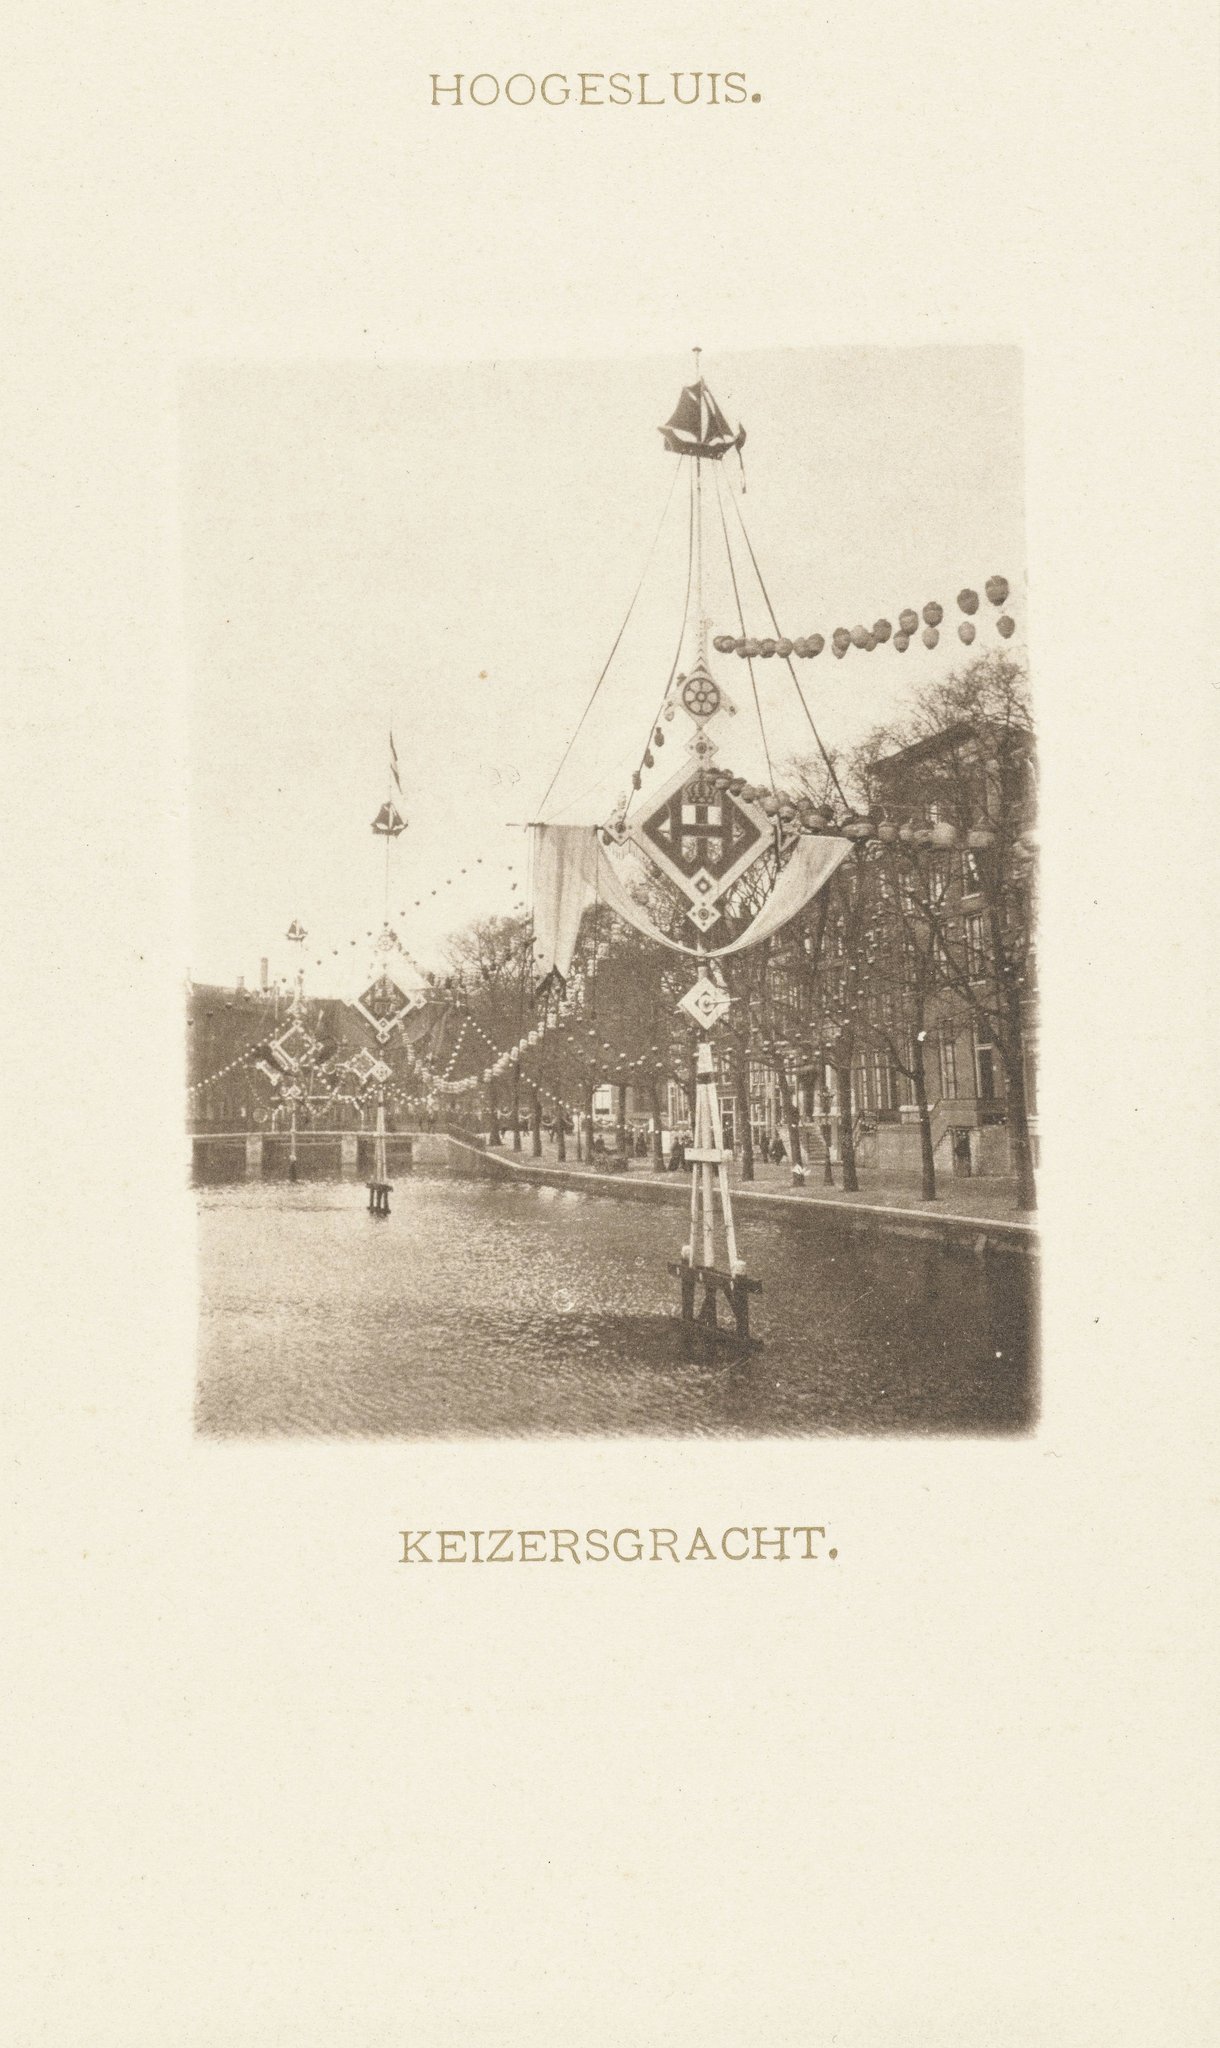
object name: photograph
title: Versiering van de Keizersgracht in Amsterdam, 5 februari 1901, feestelijkheden ter gelegenheid van het huwelijk van koningin Wilhelmina en prins Hendrik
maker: barend groote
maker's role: fotograaf, fotohandel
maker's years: 1862-1946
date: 1901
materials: paper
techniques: photograph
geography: amsterdam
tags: the hague, print maker, wilhelmina of the netherlands, decorations, honours (as symbols of the state, etc.), historical events and situations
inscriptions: annotation: ‘Keizersgracht’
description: Amsterdam, 5 februari 1901, feestelijkheden t.g.v. het huwelijk van koningin Wilhelmina en prins Hendrik